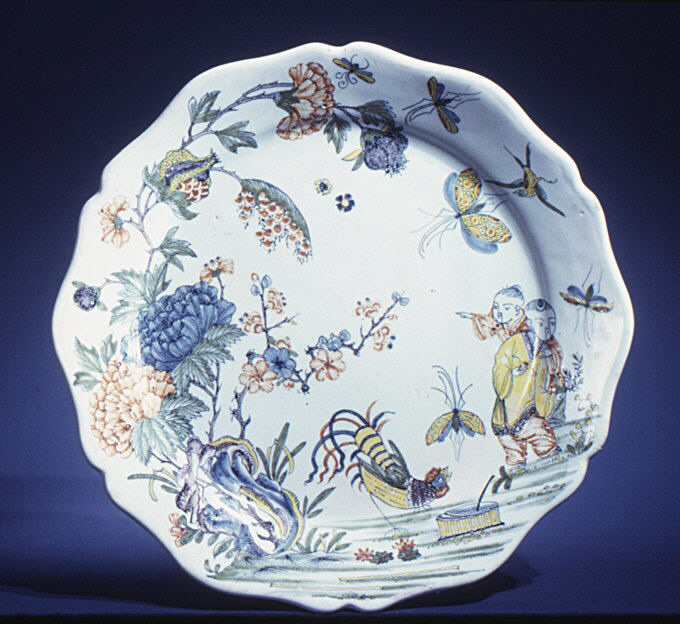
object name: plate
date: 1734-1766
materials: faience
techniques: glazing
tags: human figures,insects,butterflies,flowers